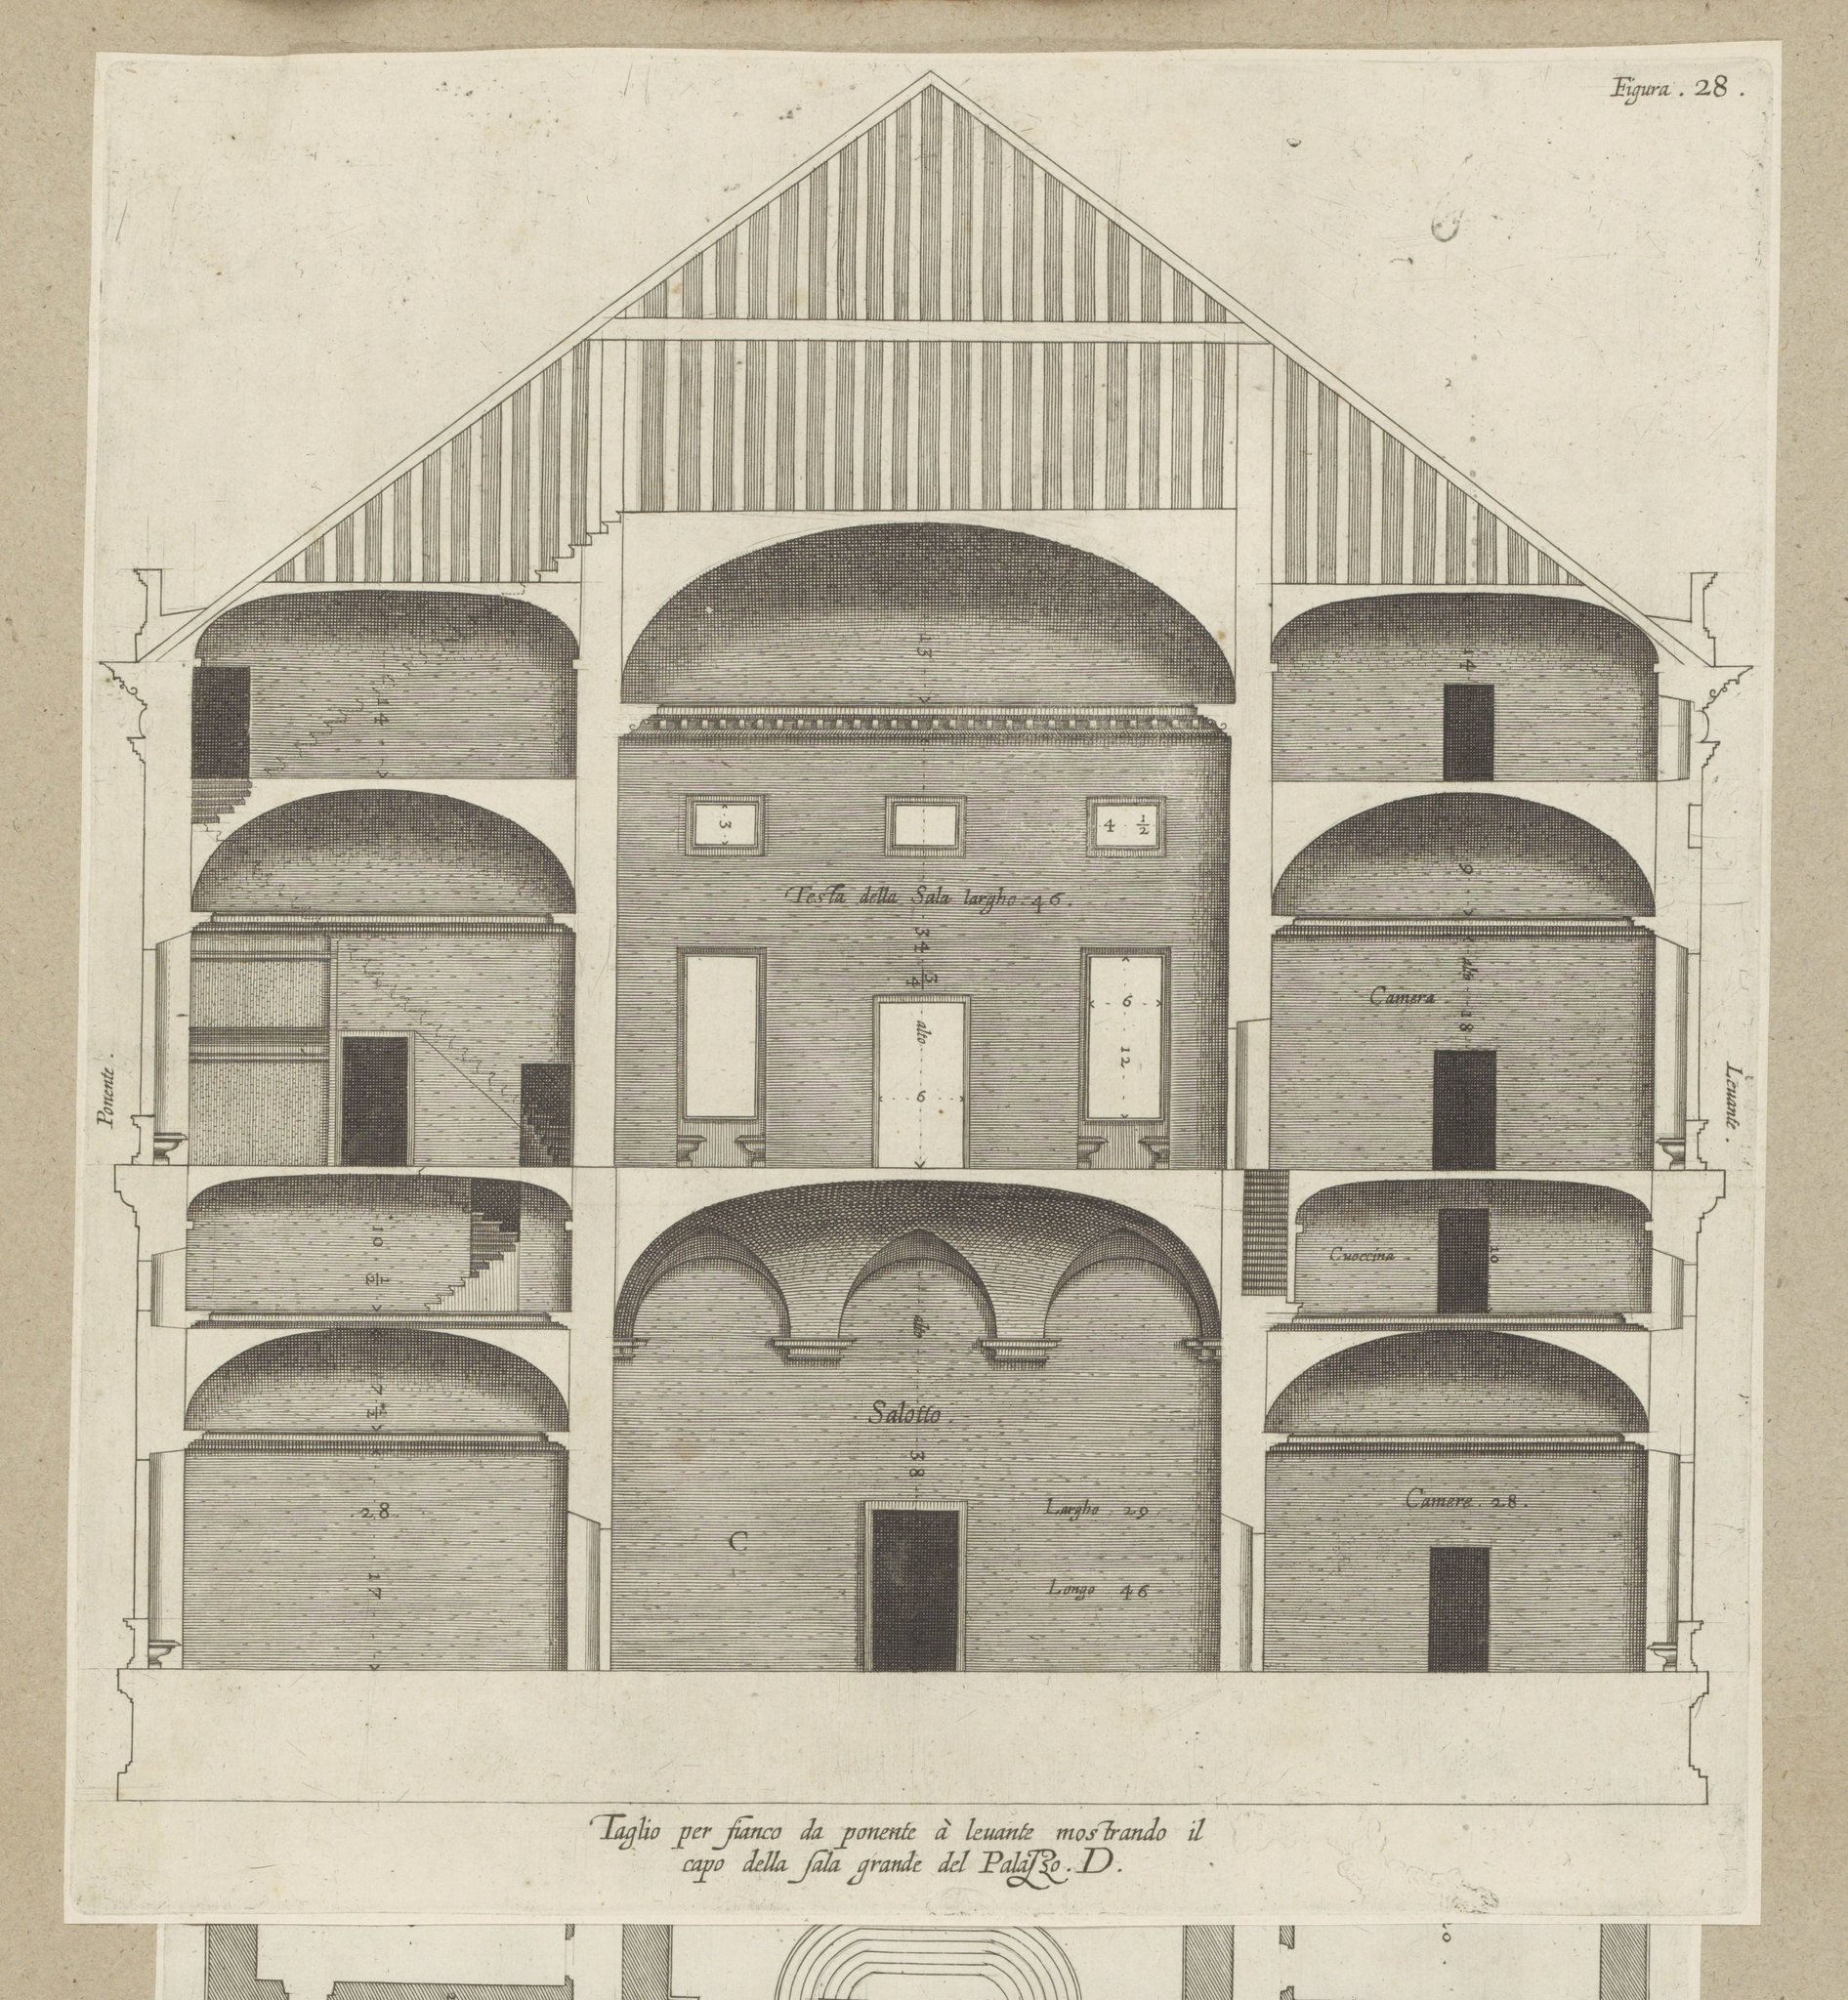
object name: album leaf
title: Langsdoorsnede van de villa Grimaldi te Genua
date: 1622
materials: paper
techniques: engraving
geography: antwerp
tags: hôtel, i.e. small palace in city - aa - civic architecture: inside, section ~ architectural design or model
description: Deze prent maakt deel uit van een album.